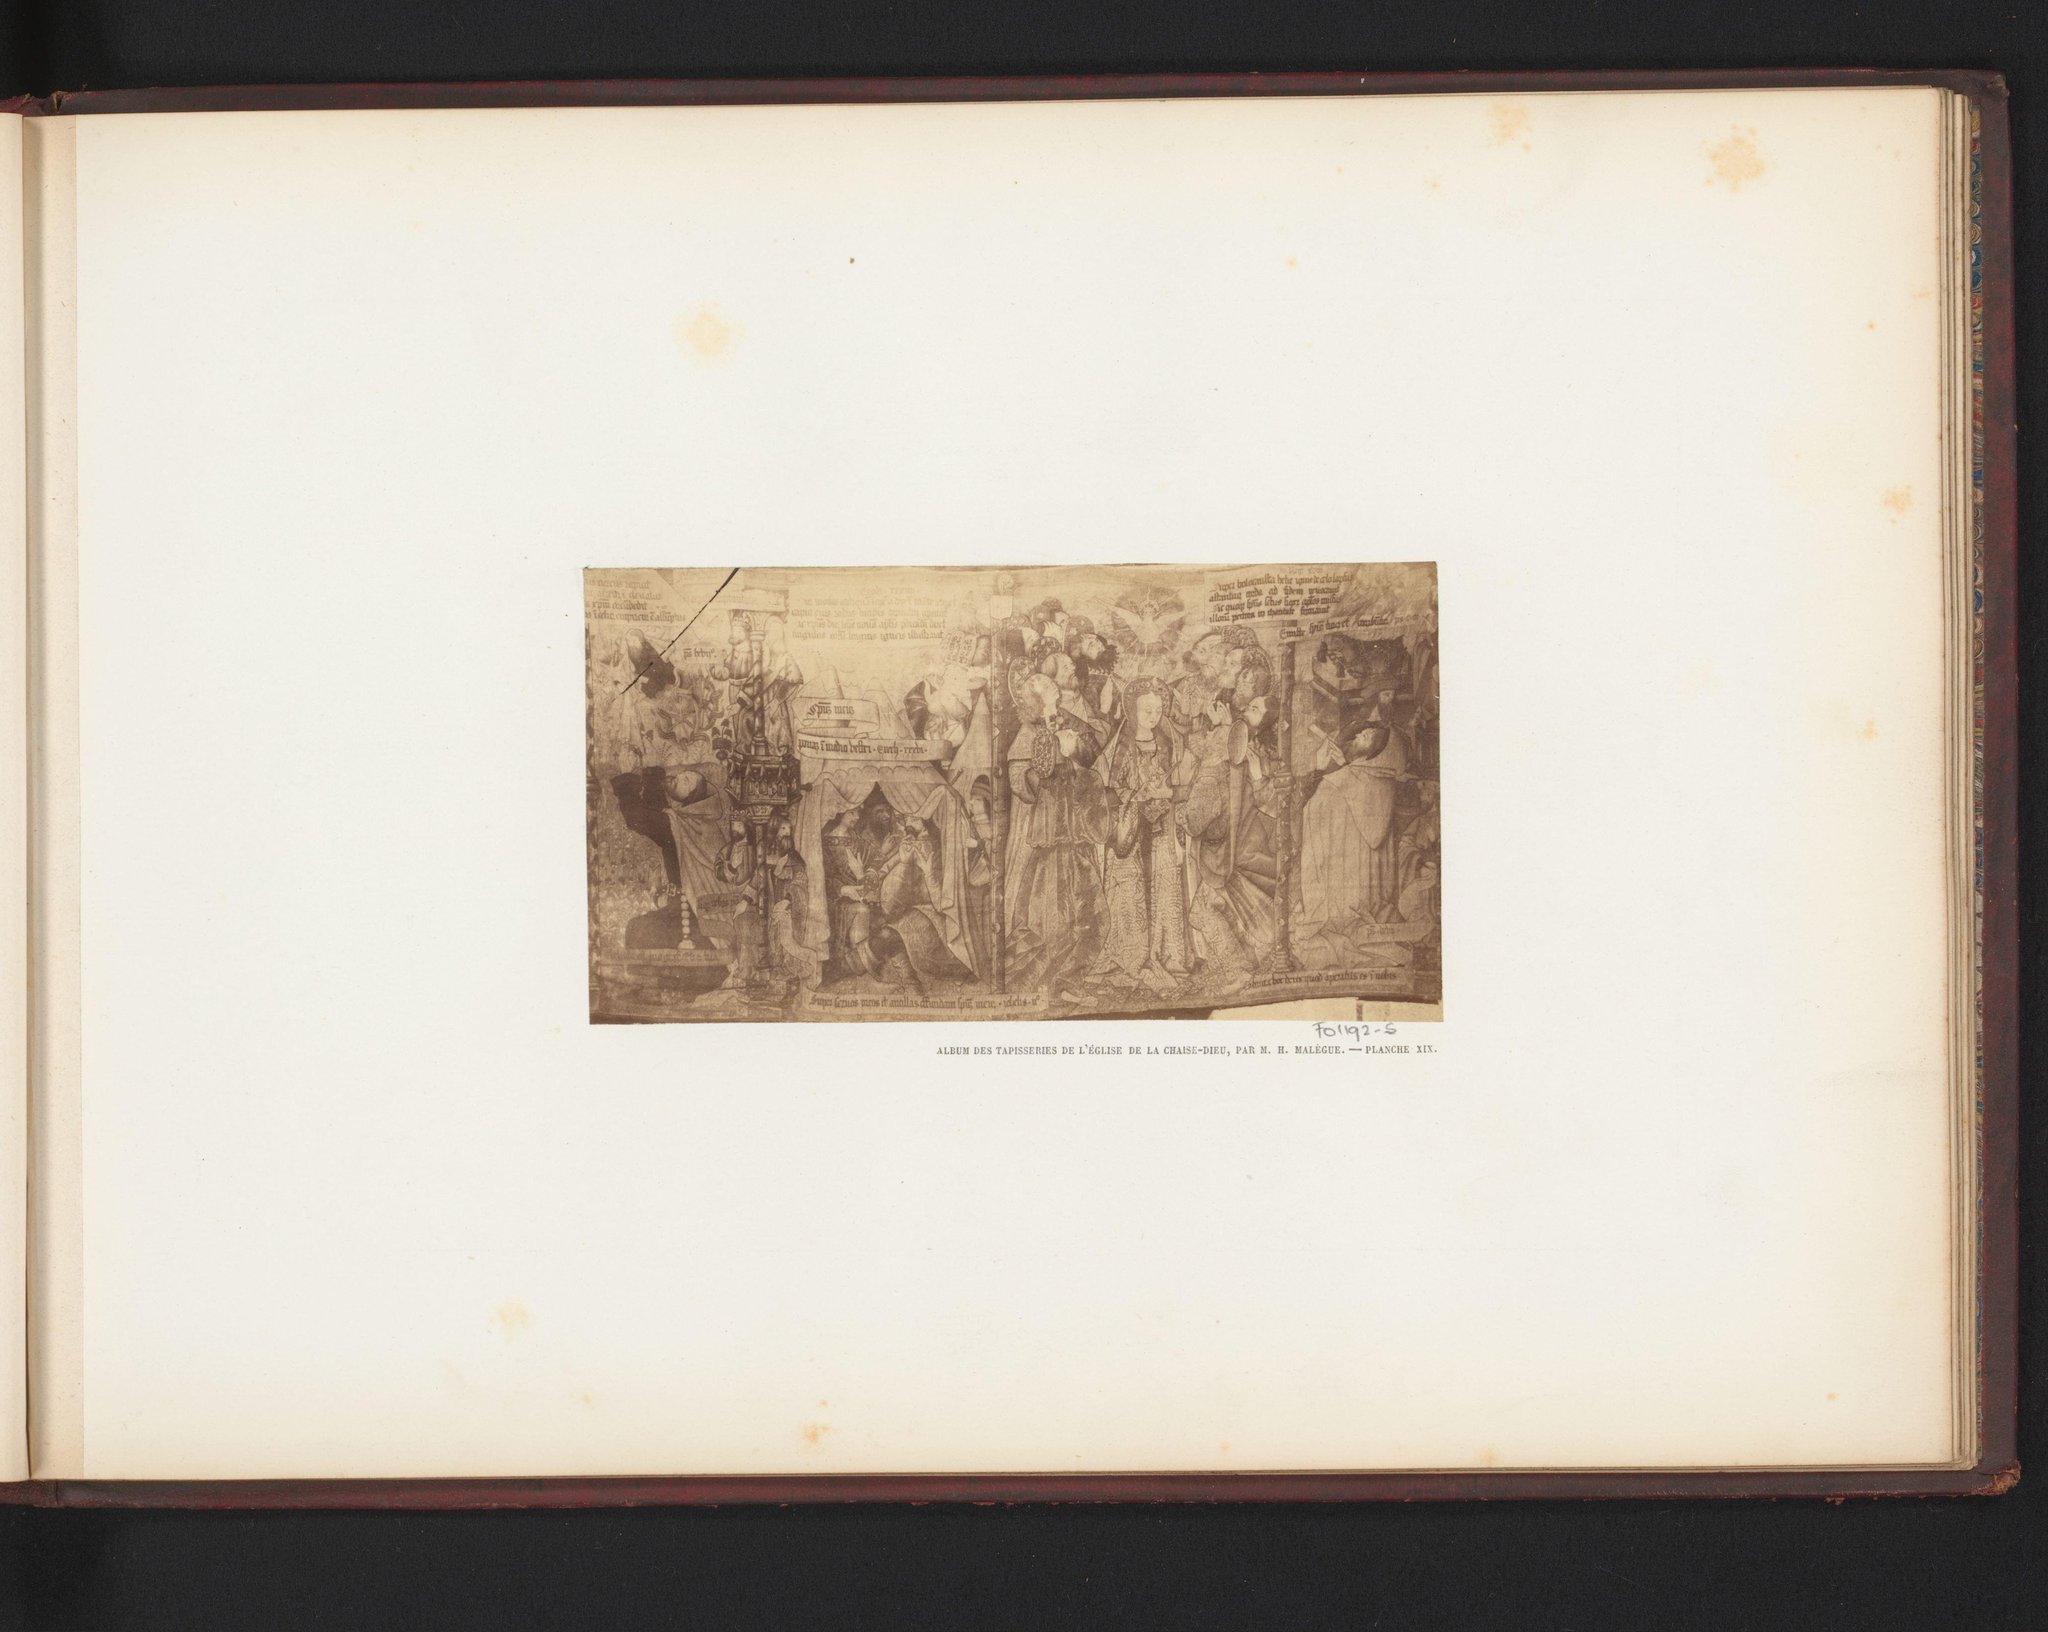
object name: photograph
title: Tapijt met de neerdaling Heilige Geest en prefiguraties in een kerk te La Chaise-Dieu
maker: hippolyte malègue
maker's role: archeoloog, fotograaf, schrijver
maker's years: 1825-1901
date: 1868-1873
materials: photographic support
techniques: albumen print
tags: tapestry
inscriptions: inscription: ‘album des tapisseries de l'église de la Chaise-Dieu, par M. H. Malegue - Planche XIV’